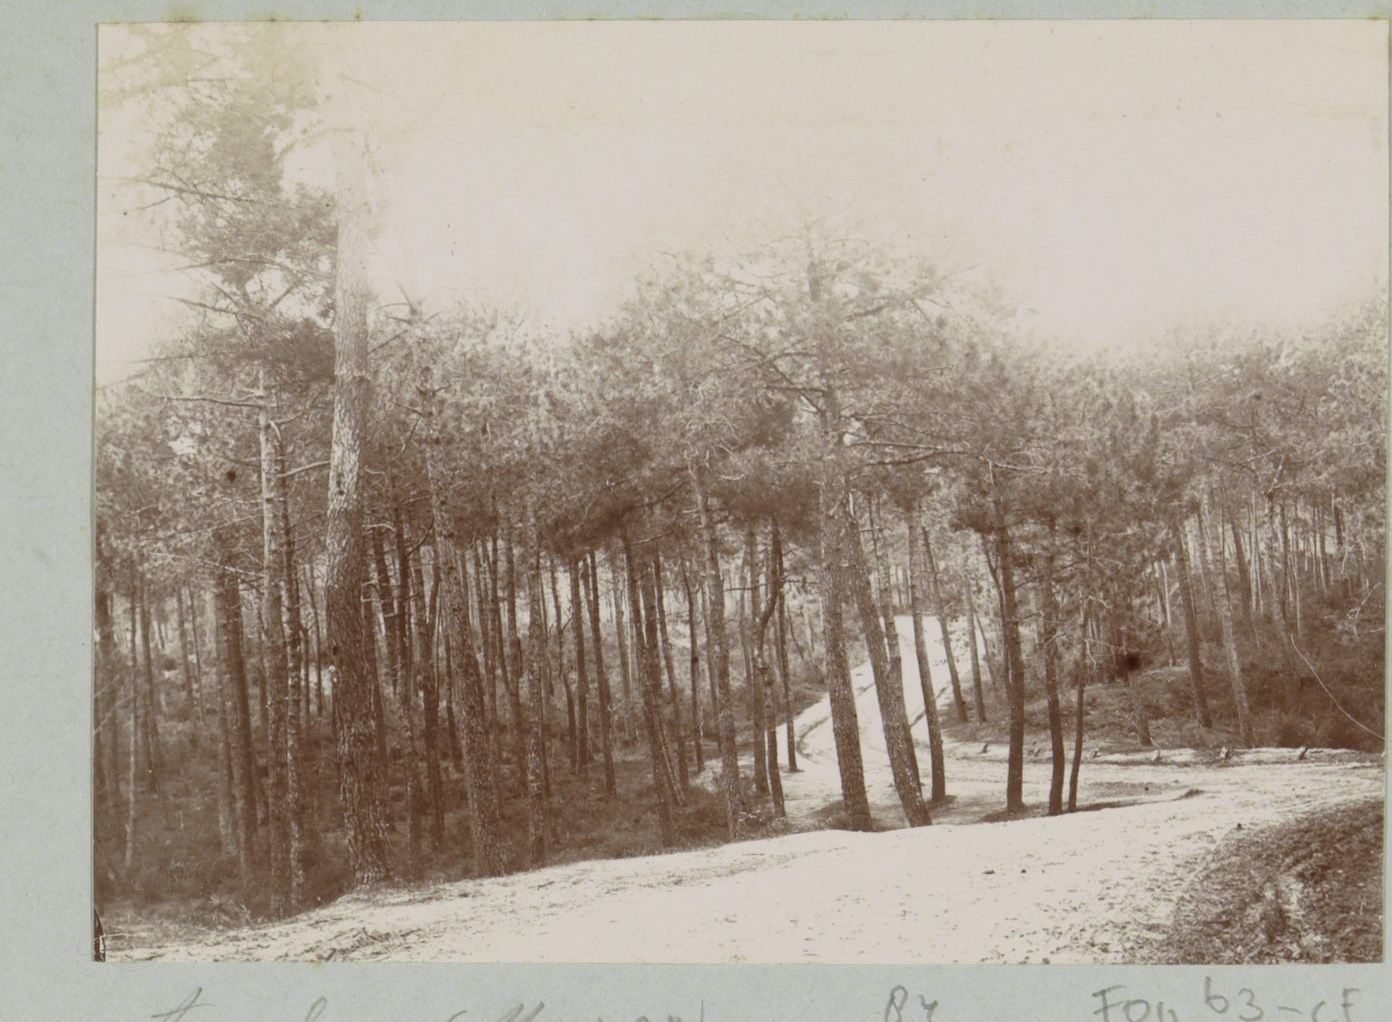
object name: photograph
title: Bos met pad bij Arachon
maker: delizy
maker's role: manufacturer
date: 1803-1897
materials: paper, photographic support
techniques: gelatin silver print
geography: arcachon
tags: road, path, forest, wood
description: Onderdeel van Fotoalbum van een Franse amateurfotograaf met opnames van uitstapjes in Frankrijk, Spanje, België, Luxemburg en Nederland, de eerste automobielen en autoraces.